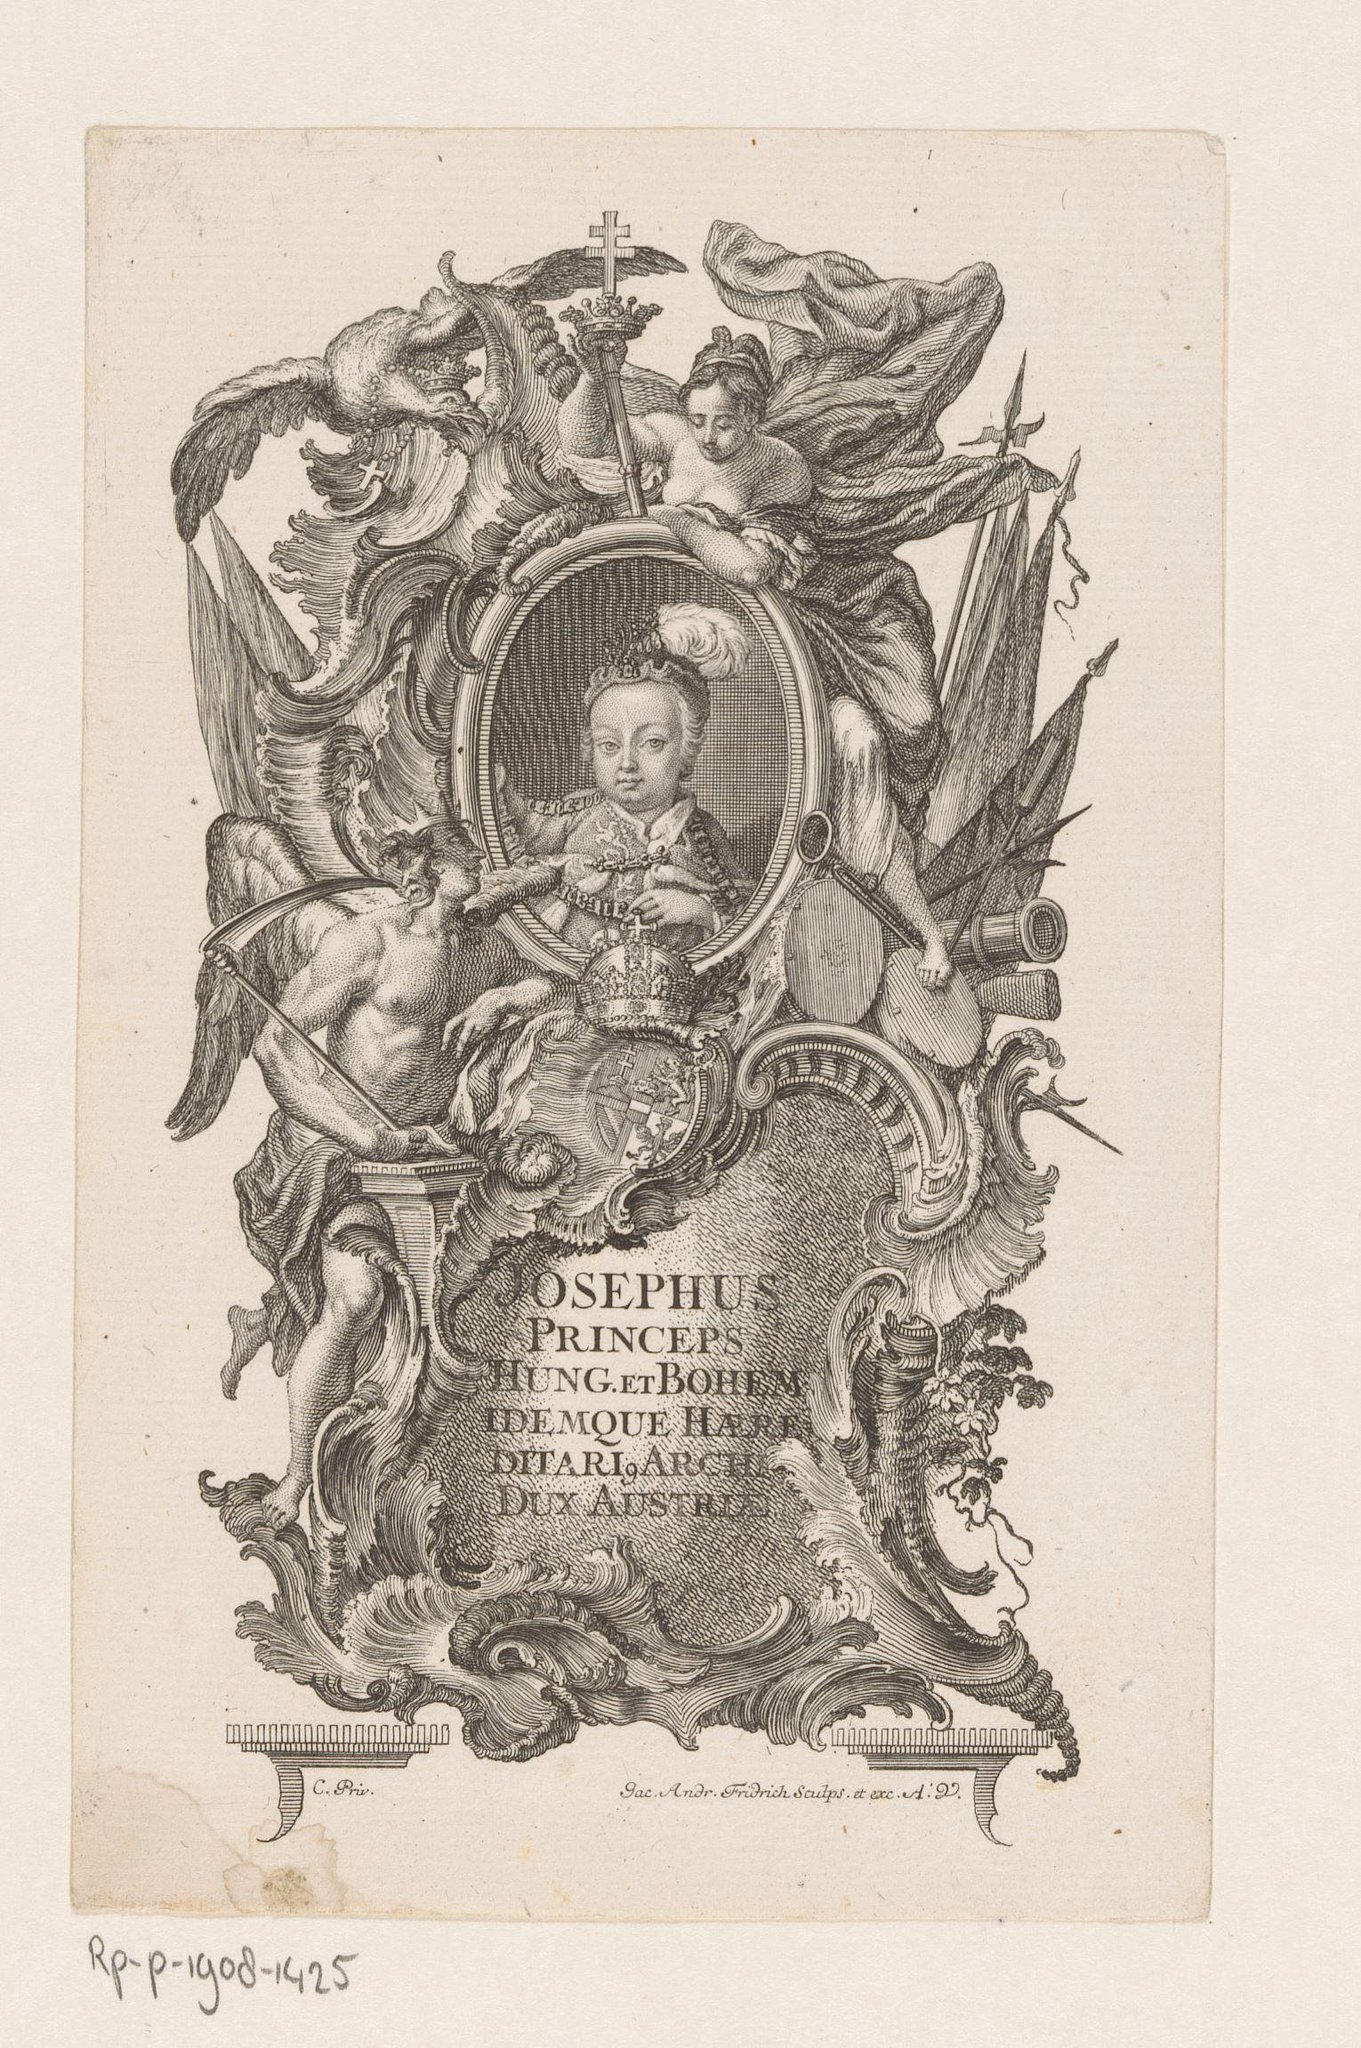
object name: print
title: Portret van Jozef II in allegorische omlijsting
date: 1751-1779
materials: paper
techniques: engraving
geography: augsburg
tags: vienna, jozef ii (duits keizer), rocaille ornament, attributes of saturn: scythe, ornament ~ medallion, historical persons, symbols, allegories of war; 'guerra' (ripa), armorial bearing, heraldry, insignia and symbols of sovereignty (crown, diadem, sceptre, orb, seal, standard, cloak, pectoral)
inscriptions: collector's mark: Lugt 2228